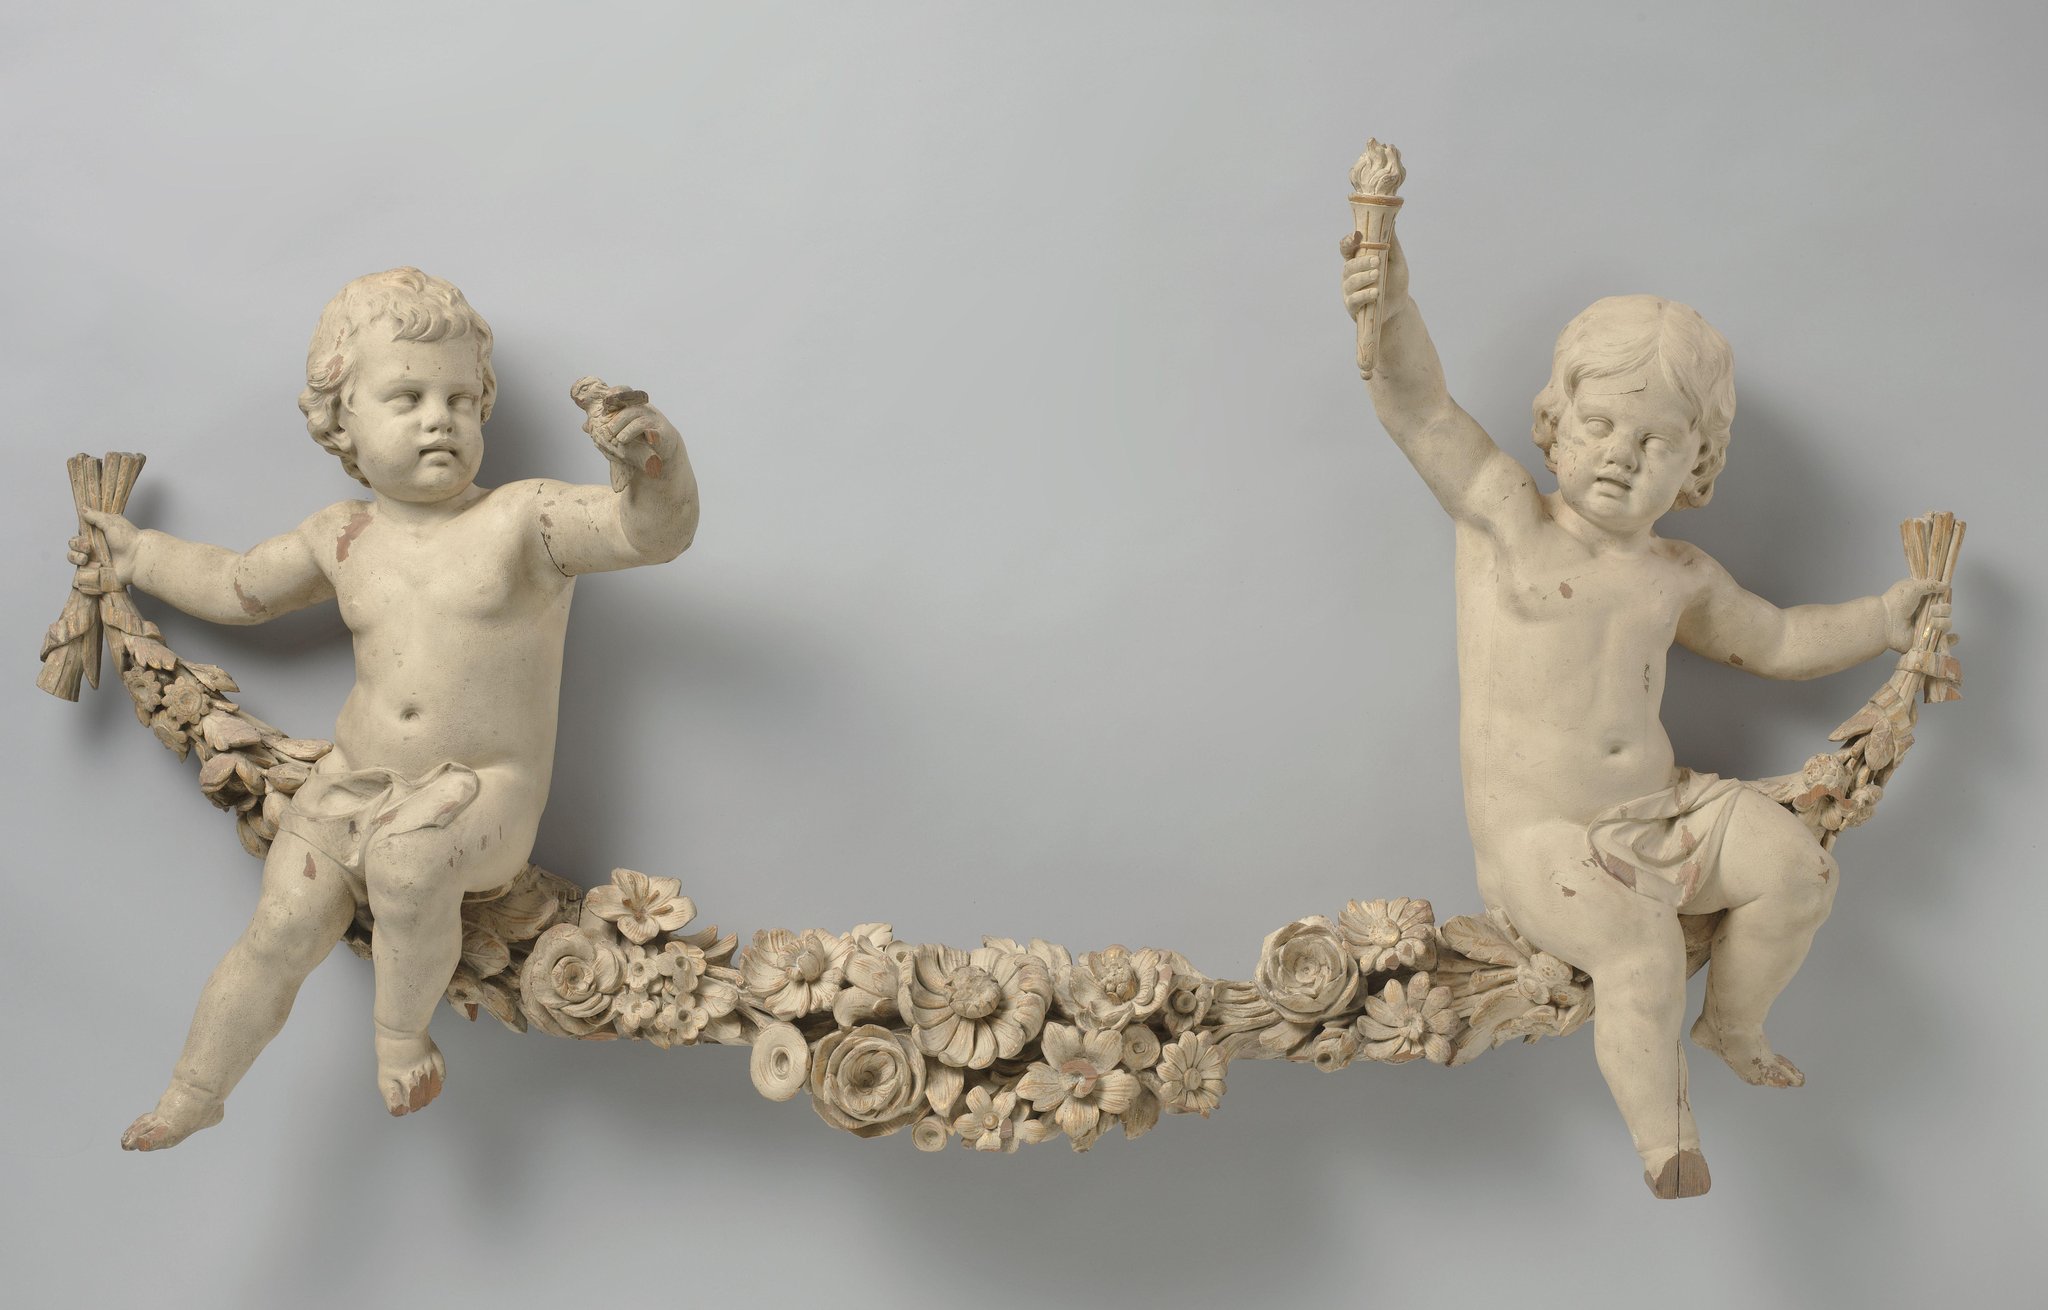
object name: sculpture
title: De vier elementen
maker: michiel emanuel shee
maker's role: sculptor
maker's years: -1740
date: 1730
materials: wood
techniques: cutting, painted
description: Putto op guirlande fragment met vogel in hand.